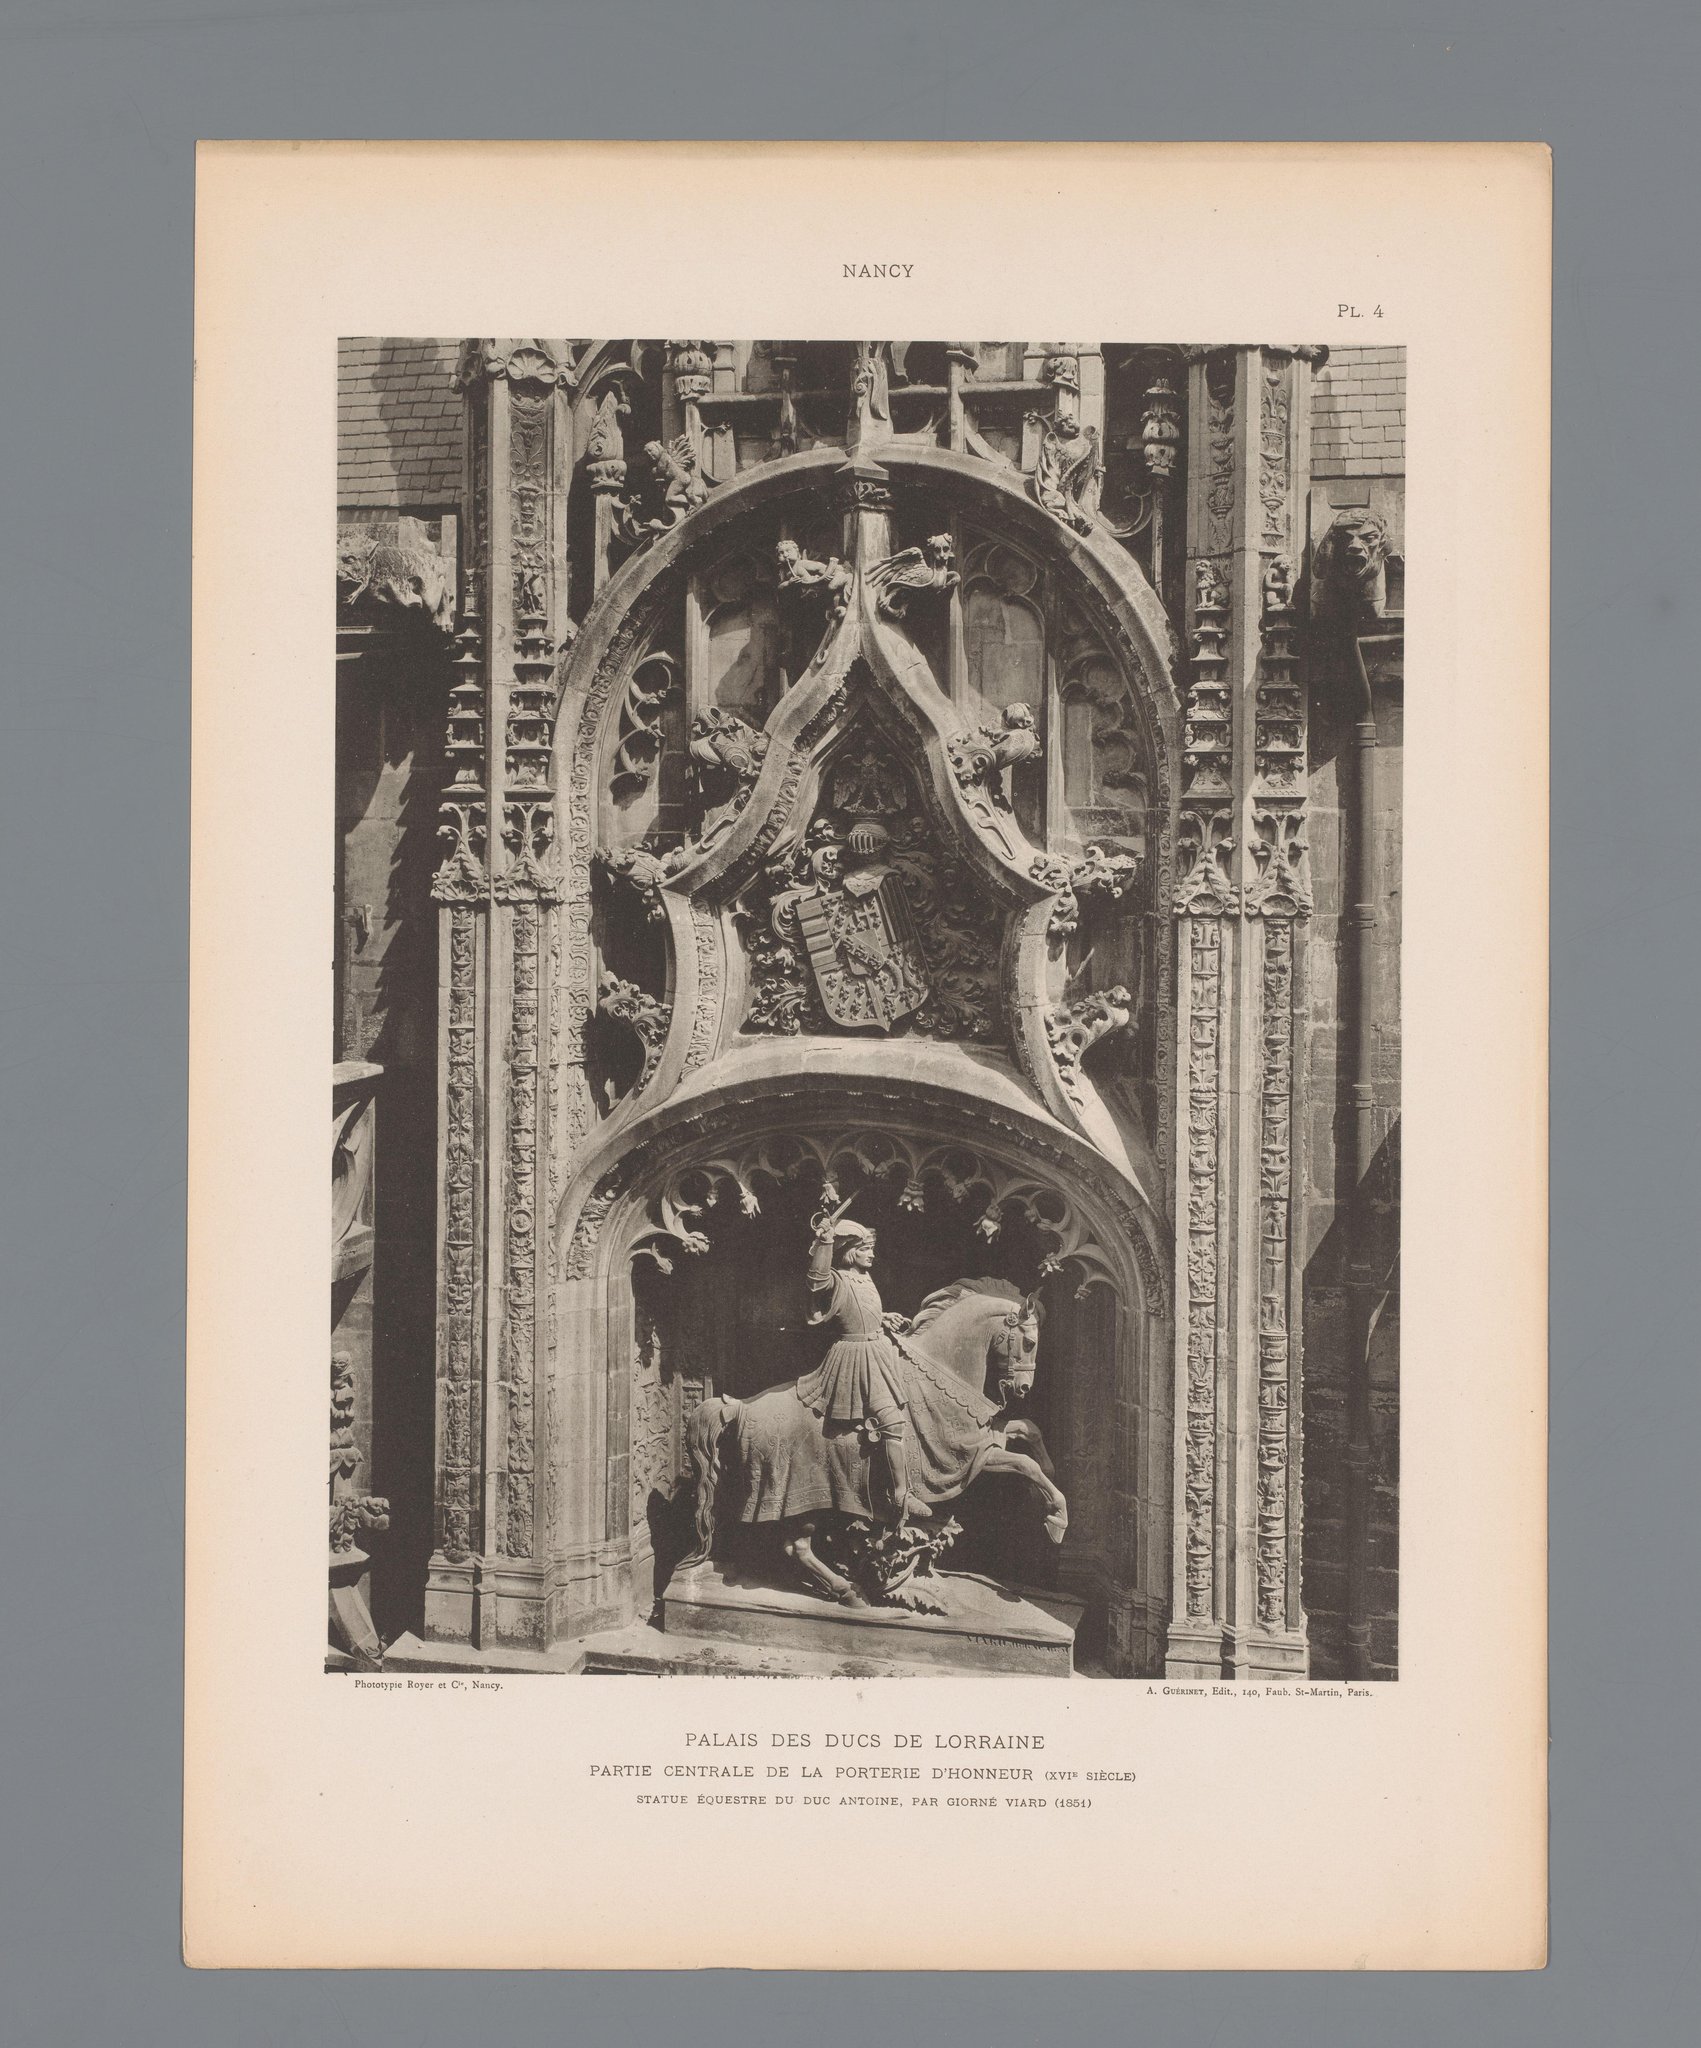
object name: photomechanical print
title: Reliëfs boven de ingang van Musée Lorrain te Nancy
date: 1891-1896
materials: paper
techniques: photograph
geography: paris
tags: gate, entrance, sculpture (+ relief ~ sculpture)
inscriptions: inscription: ‘Palais des Ducs de Lorraine (...)’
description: Deze prent maakt deel uit van een omslag met 103 prenten op 101 bladen en een titelblad.